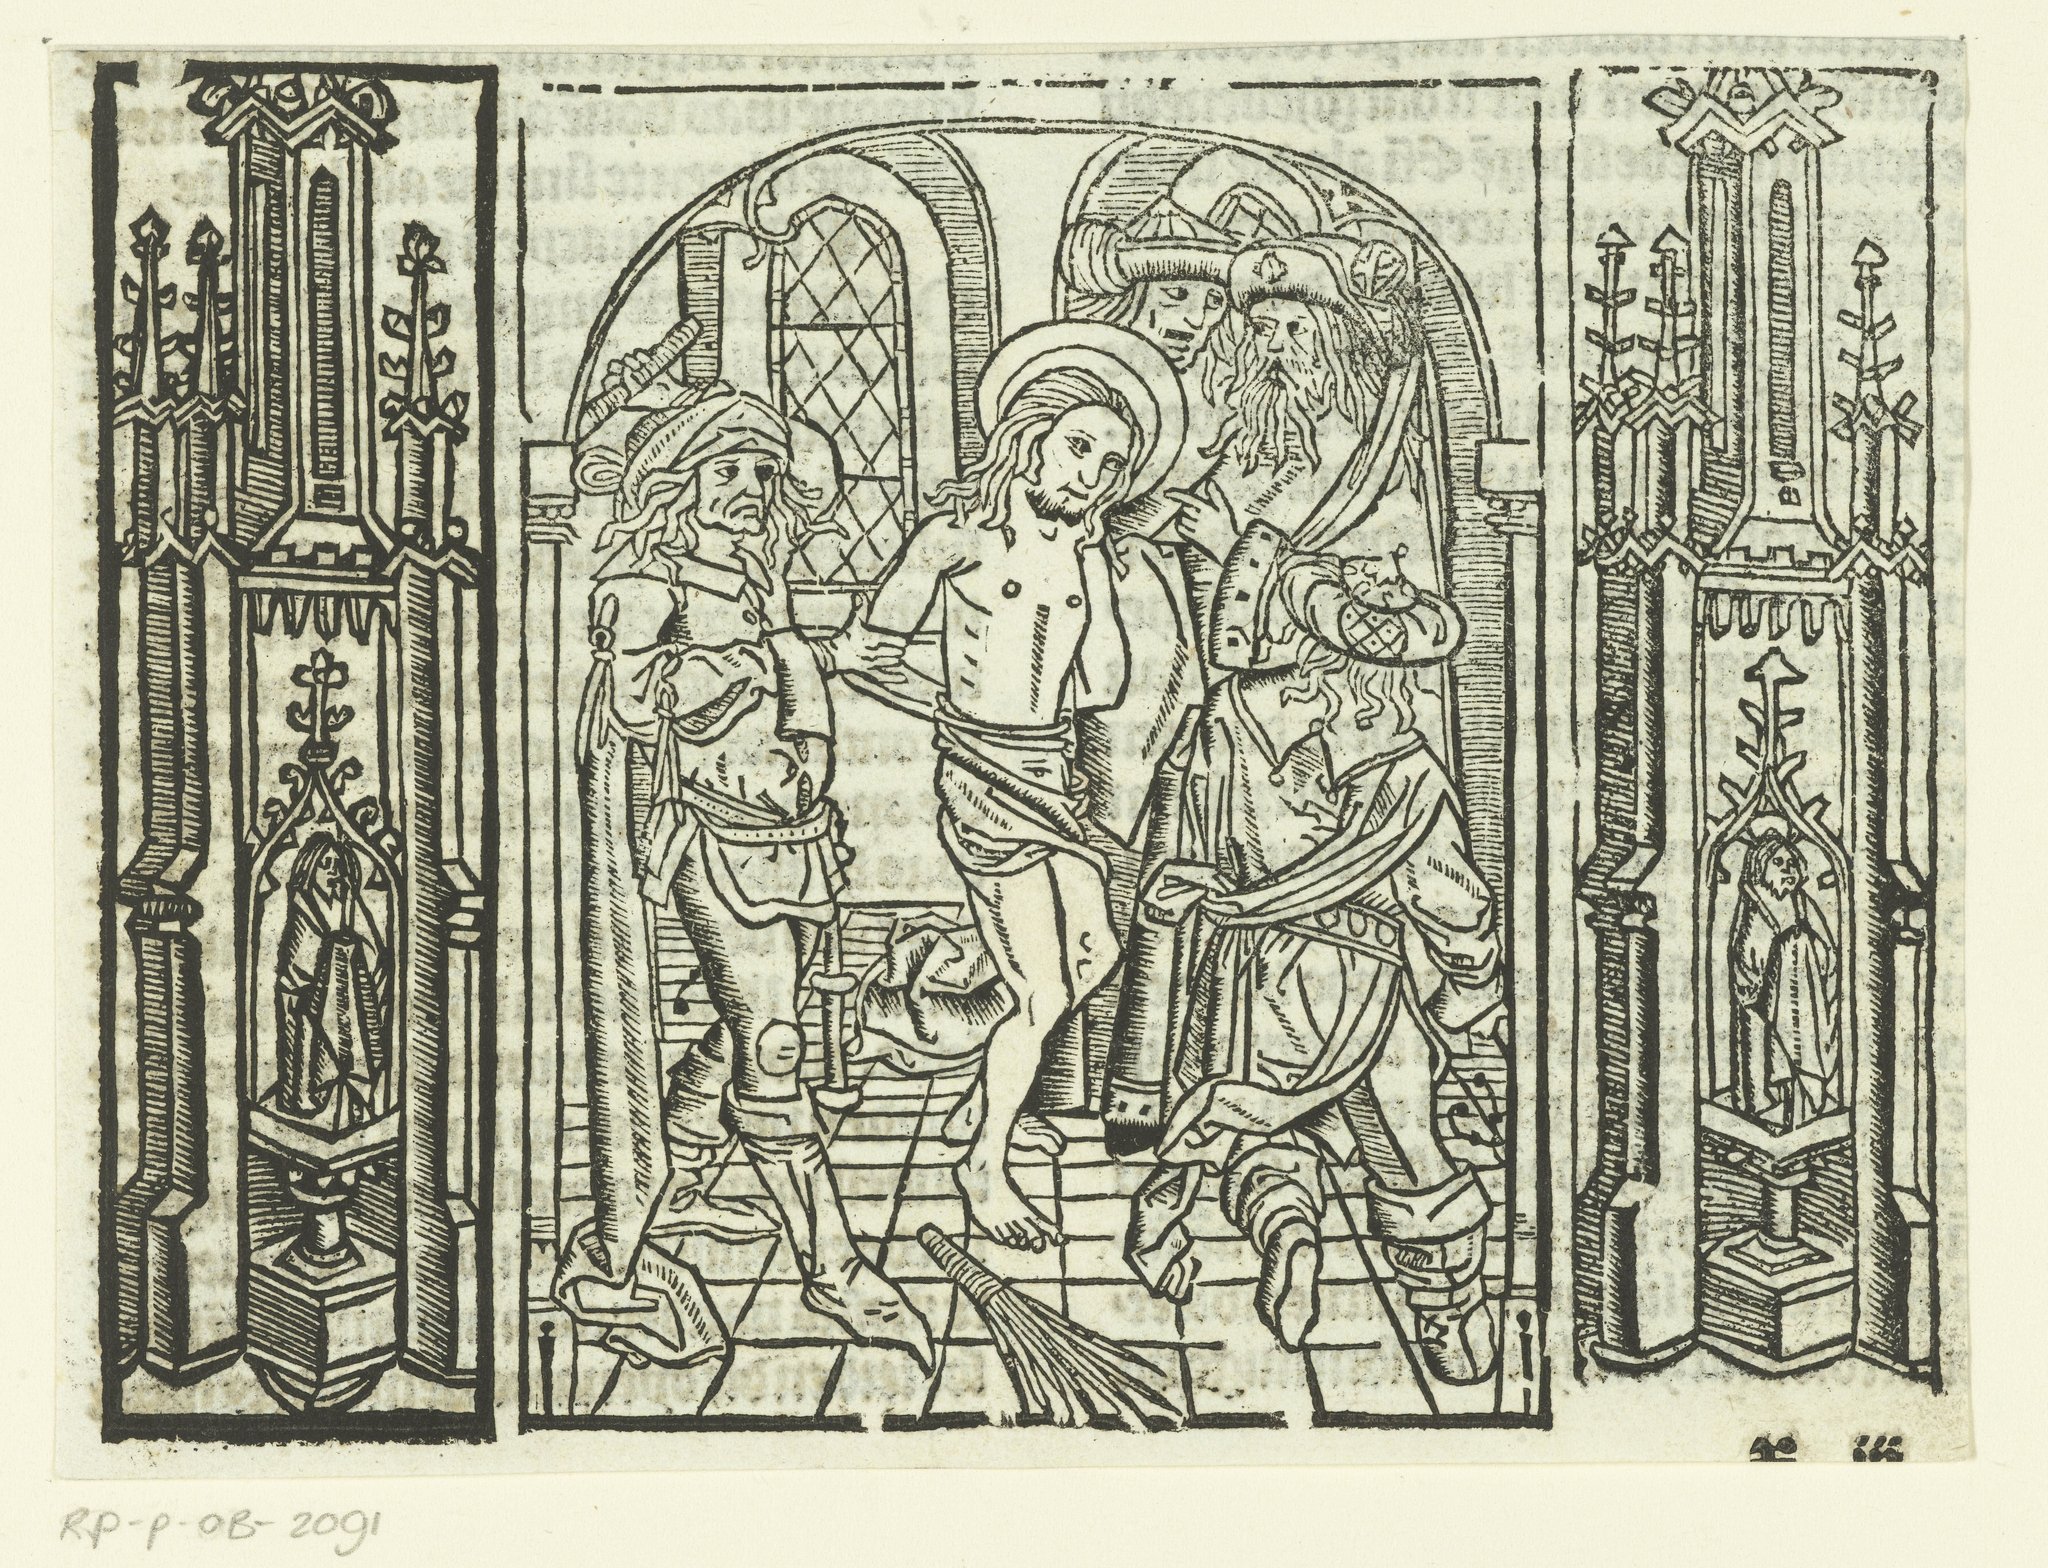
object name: book illustration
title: De geseling van Christus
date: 1480-1500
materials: paper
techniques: woodcut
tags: flagellation by soldiers, christ usually tied to a column (matthew 27:26; mark 15:15; john 19:1)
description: Eén blad van 113 uit Ludolphus de Saxonia, "Dit es dleué ons liefs heeren ihesu christi". Anonieme Nederlandse vertaling. Uitgegeven door Henrick Eckert van Homberch te Antwerpen in 1503. Botke, K. Deze 113 houtsneden, die meestal reeds in vroege Nederlandse boeken gebruikt zijn, worden toegeschreven aan de tweede Meester van Delft, de Meester van de Delbecq-Schreiber-passie en de Meester van de Virgo inter Virgines. In Conway (1884) en in "De gulden passer"(1951) zijn ook eerdere versies opgenomen. Botke, K.